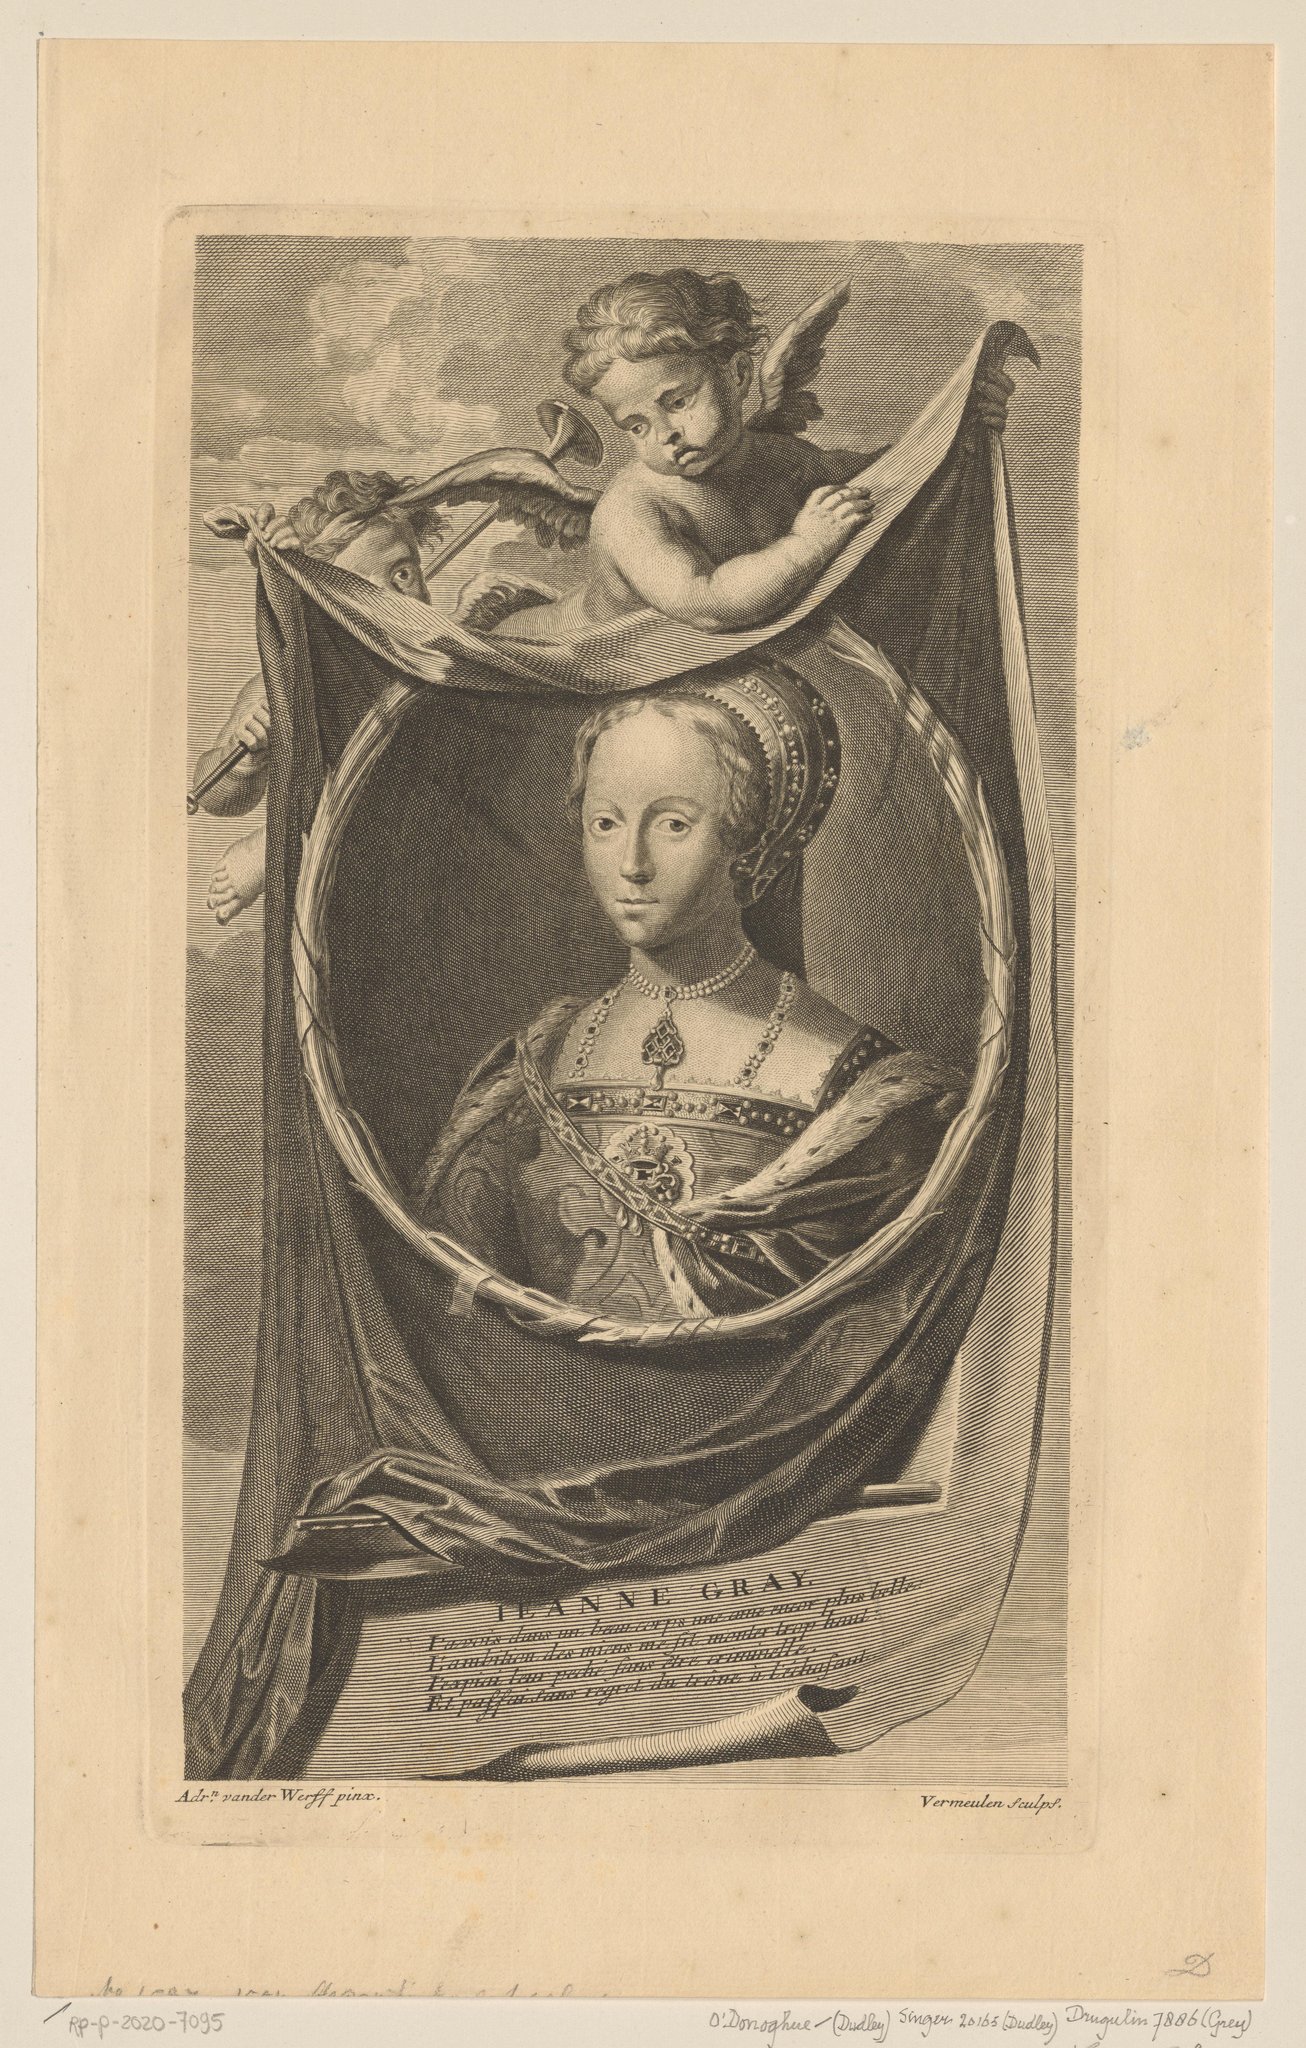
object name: print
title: Portret van Jane Grey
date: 1654-1708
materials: paper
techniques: engraving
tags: london, historical persons, queen, cupids: 'amores', 'amoretti', 'putti'